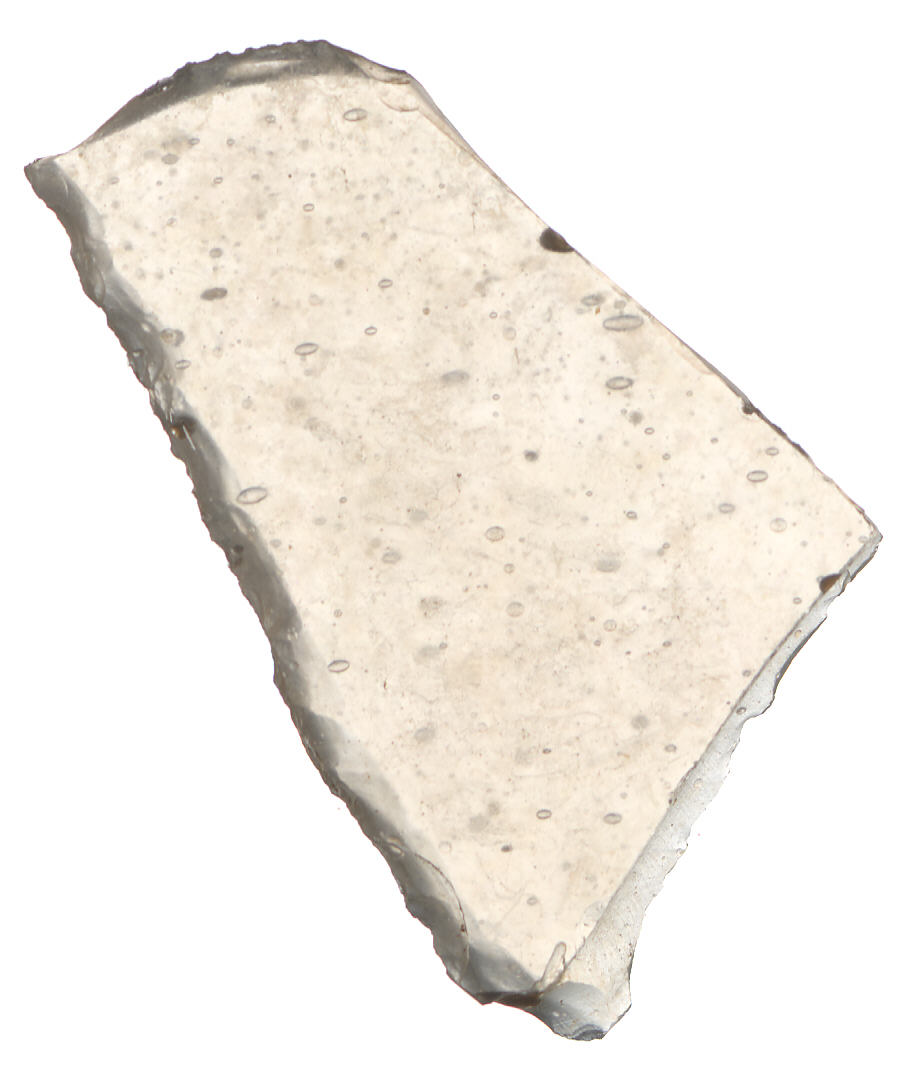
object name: fragment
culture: crusader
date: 1201-1300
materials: glass